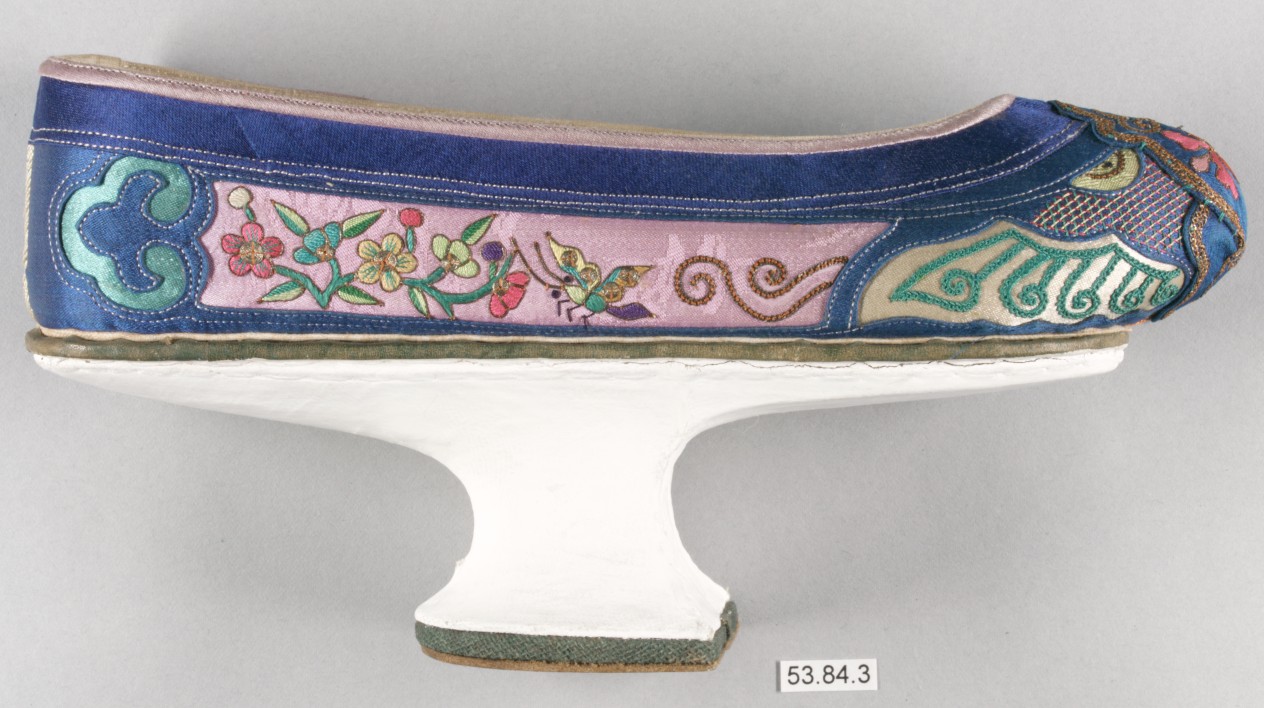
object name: woman's shoe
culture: chinese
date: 1801-2000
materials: leather, metal thread, textile, silk